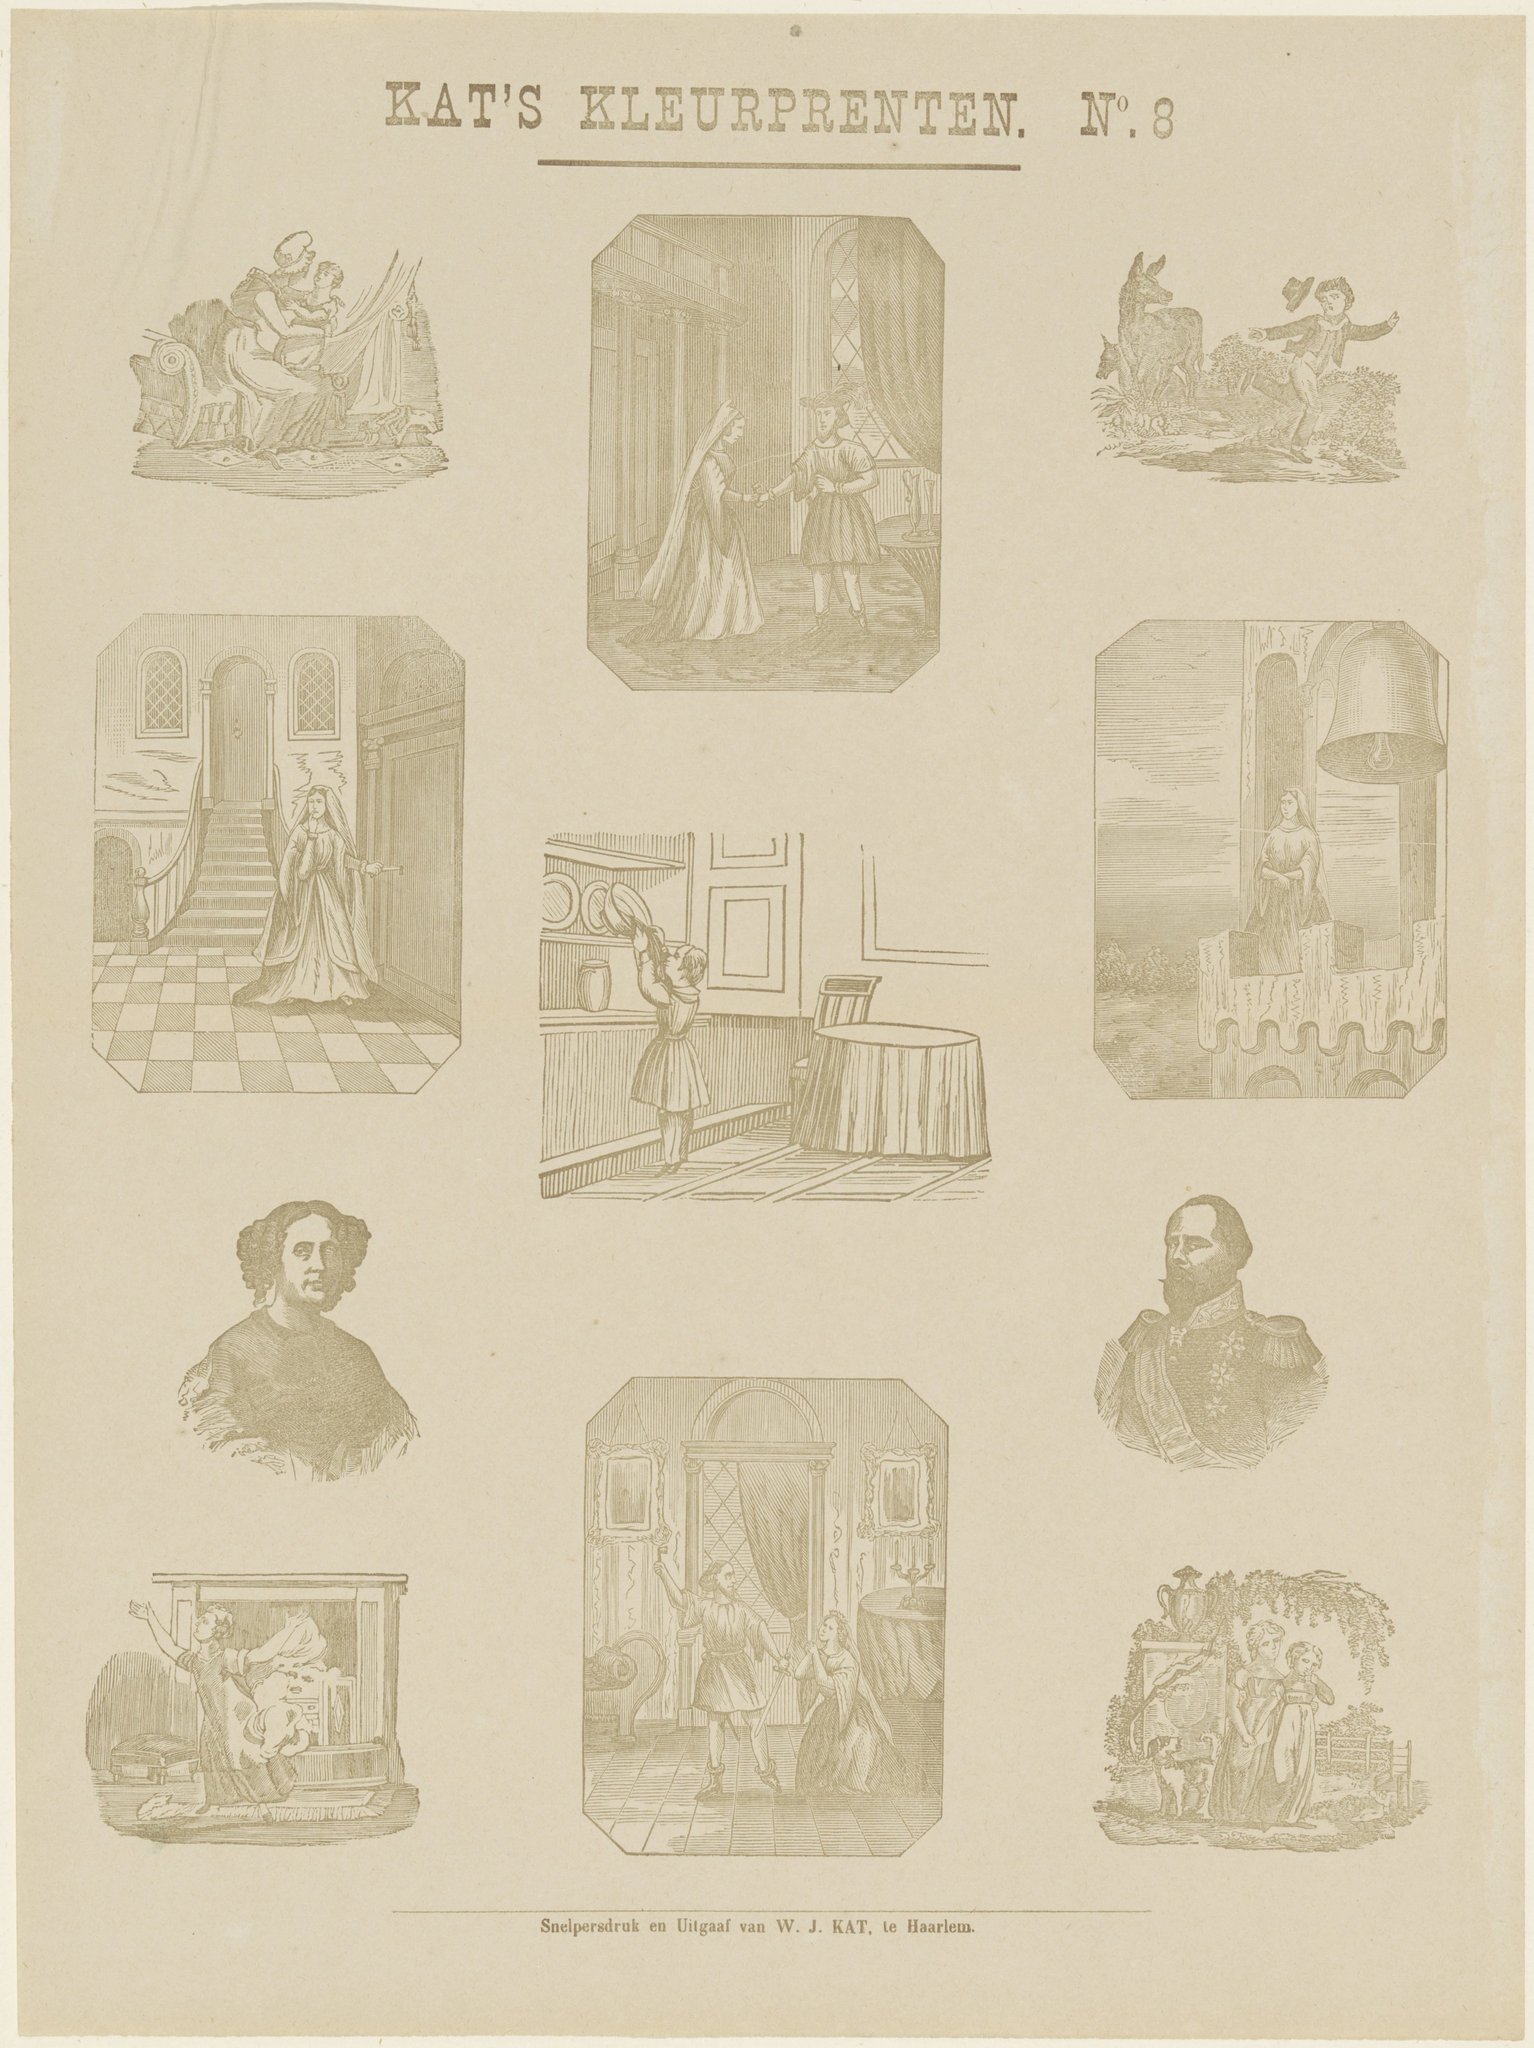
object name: popular print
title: Verschillende voorstellingen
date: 1862-1882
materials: paper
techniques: engraving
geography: haarlem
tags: man and animal (+ animal(s) attacking), kitchen, tales and fairy tales, tales and fairy tales (with title)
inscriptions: collector's mark: Lugt 2760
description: Blad met 11 afbeeldingen van verschillende onderwerpen, bedoeld om uit te knippen en in te kleuren. Weergegeven zijn onder meer een moeder en kind op een sofa, vier taferelen van Blauwbaard, een jongen die vlucht voor een ezel en een kind bij een keukenkast met borden. Genummerd rechtsboven: No. 8.